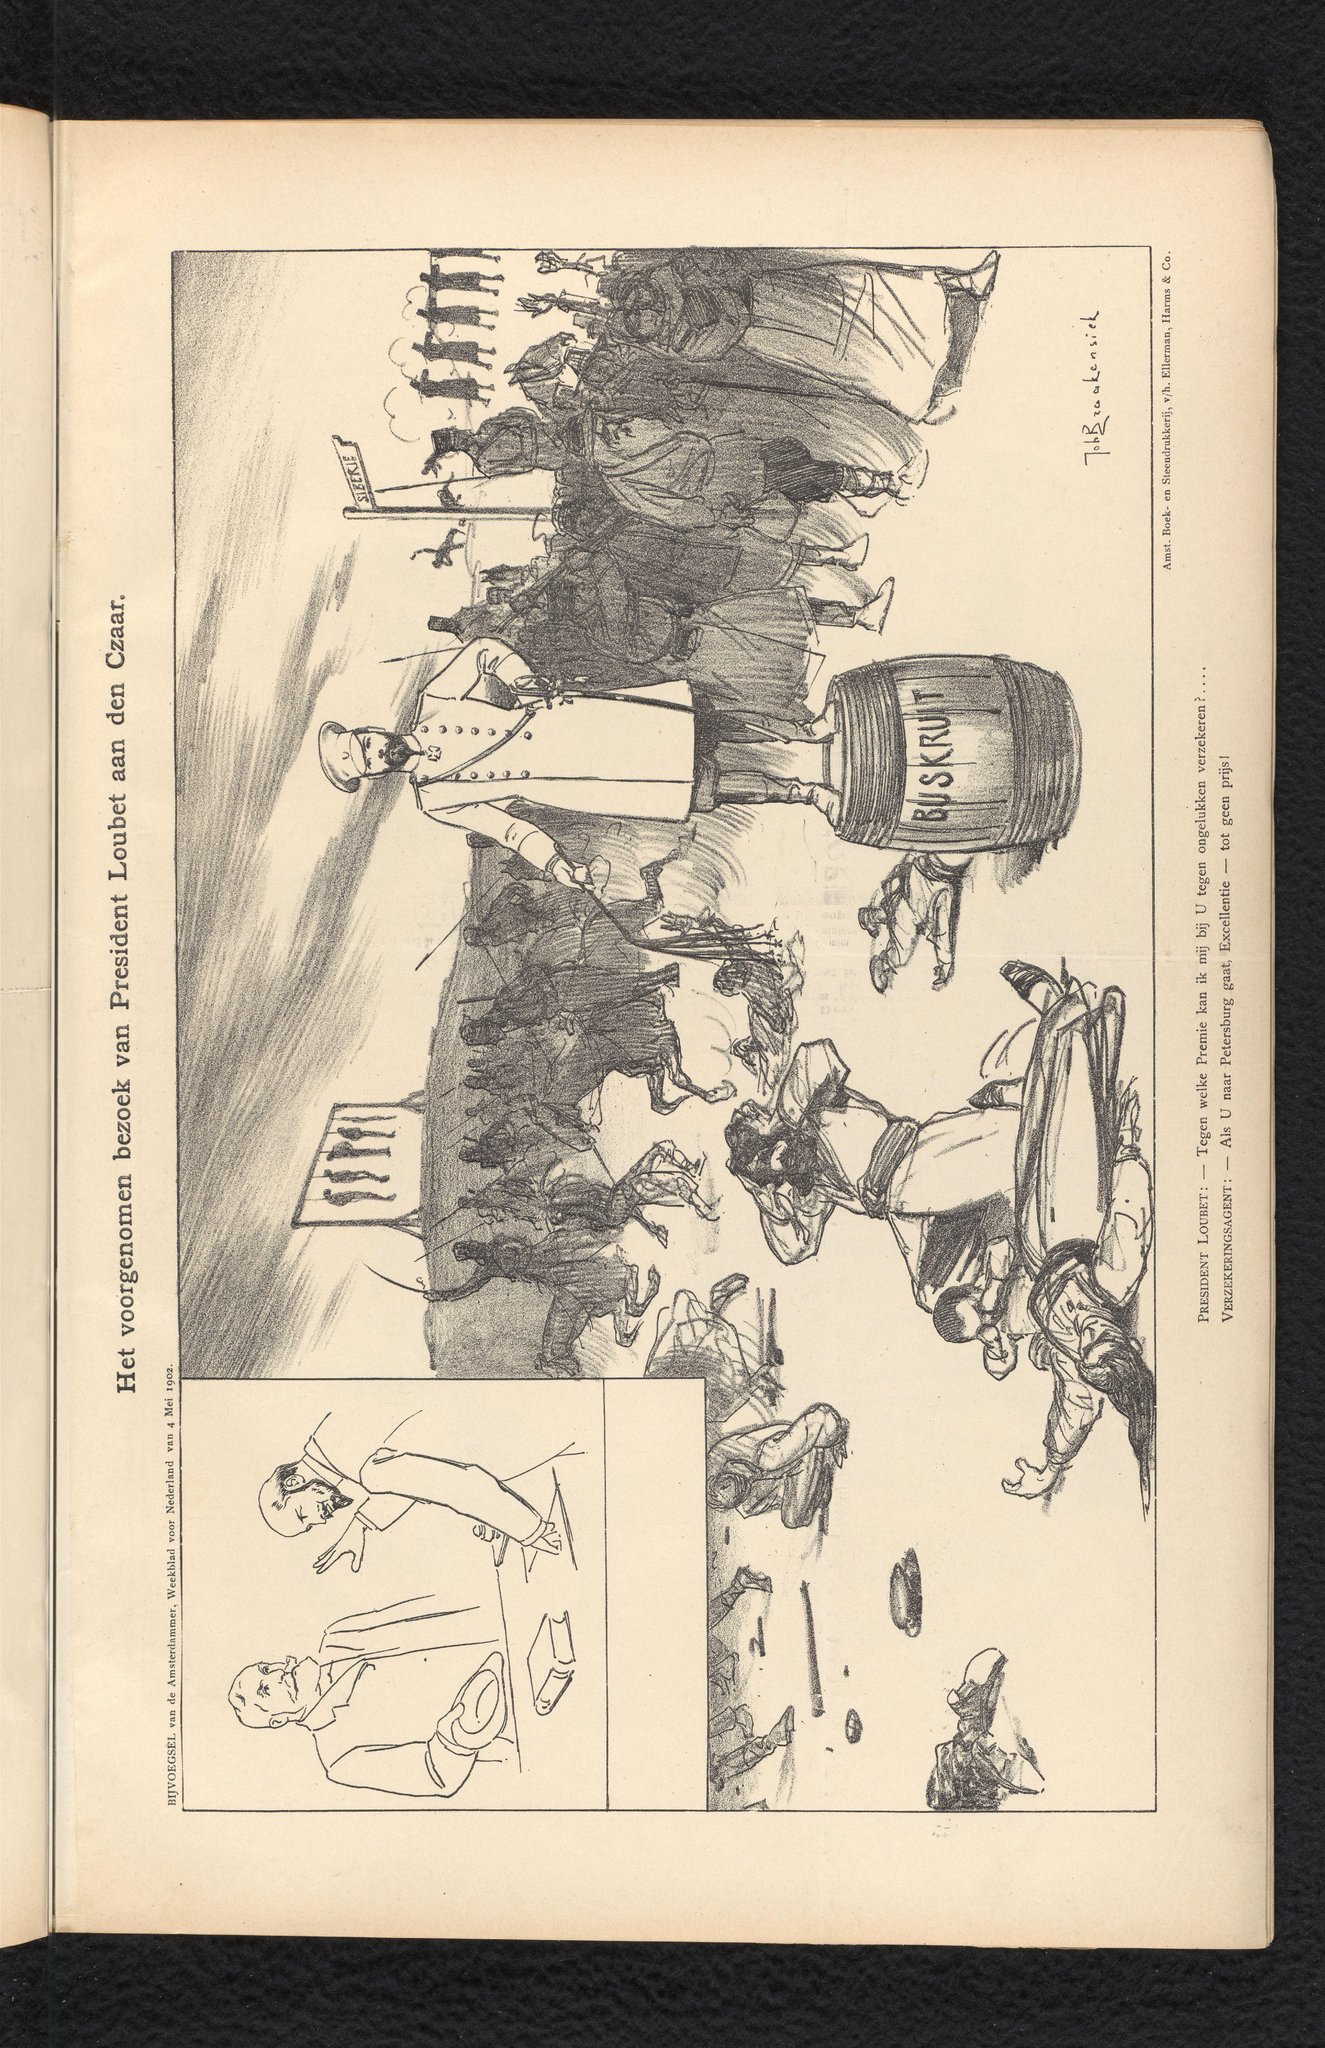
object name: cartoon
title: Het voorgenomen bezoek van President Loubet aan den Czaar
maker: johan braakensiek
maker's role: draughtsman, print maker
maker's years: 1858-1940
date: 1902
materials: paper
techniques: lithograph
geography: amsterdam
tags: horrors of war, political caricatures and satires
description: De Russische tsaar Nicolaas staande op een vat buskruit met een gesel in de hand. Om hem heen scènes van verbanning naar Siberië, moord en verdrukking van het Russische volk door het leger. In de inzet linksboven probeert president Loubet tevergeefs een reisverzekering af te sluiten.